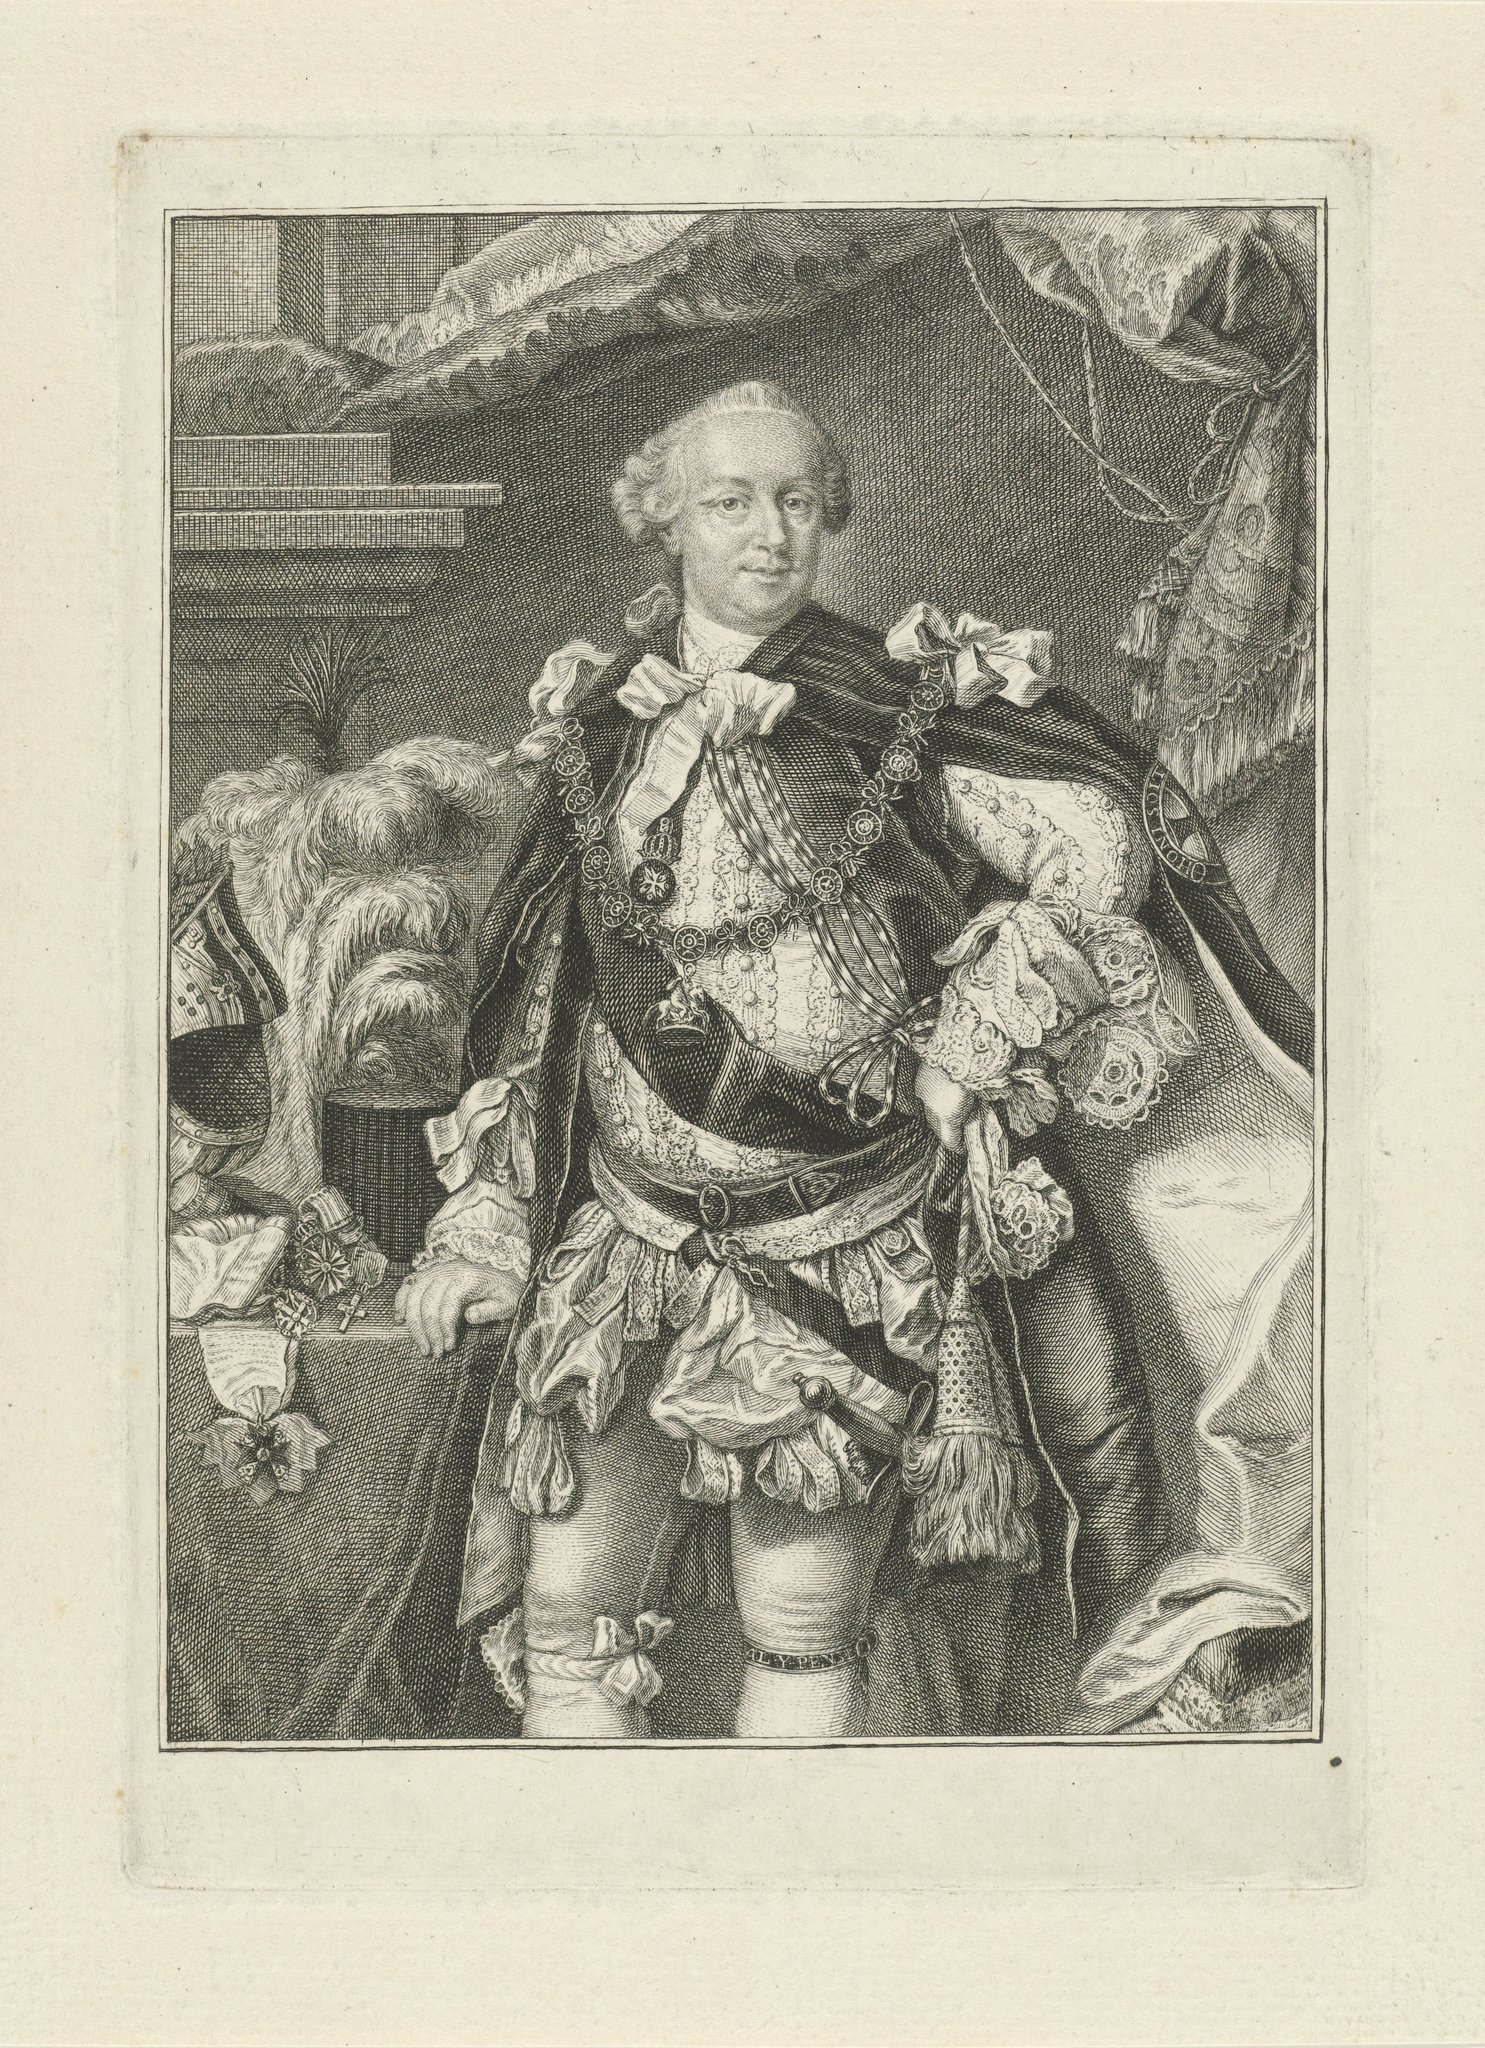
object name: print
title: Portret van Ferdinand hertog van Brunswijk-Lüneburg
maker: jacob houbraken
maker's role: draughtsman, print maker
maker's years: 1698-1780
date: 1775-1777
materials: paper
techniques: engraving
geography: amsterdam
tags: commander-in-chief, general, marshal, warfare; military affairs (+ commander-in-chief)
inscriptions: collector's mark: Lugt 240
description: Kniestuk van Ferdinand hertog van Brunswijk-Lüneburg in militair uniform, in een interieur. Zijn rechterhand leunt op een tafel naast hem, waarop divertse insignes en een helm.